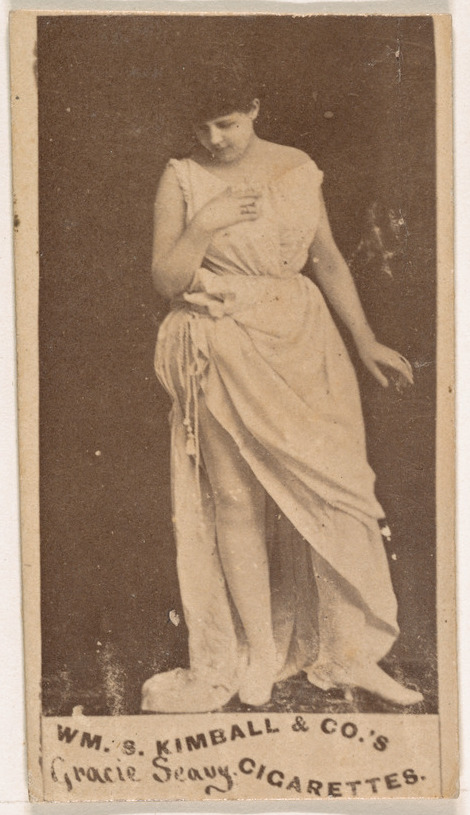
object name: photograph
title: Gracie Seavy, from the Actresses series (N203) issued by Wm. S. Kimball & Co.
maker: william s. kimball & company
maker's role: publisher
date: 1889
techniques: color lithograph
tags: portraits,women,actresses